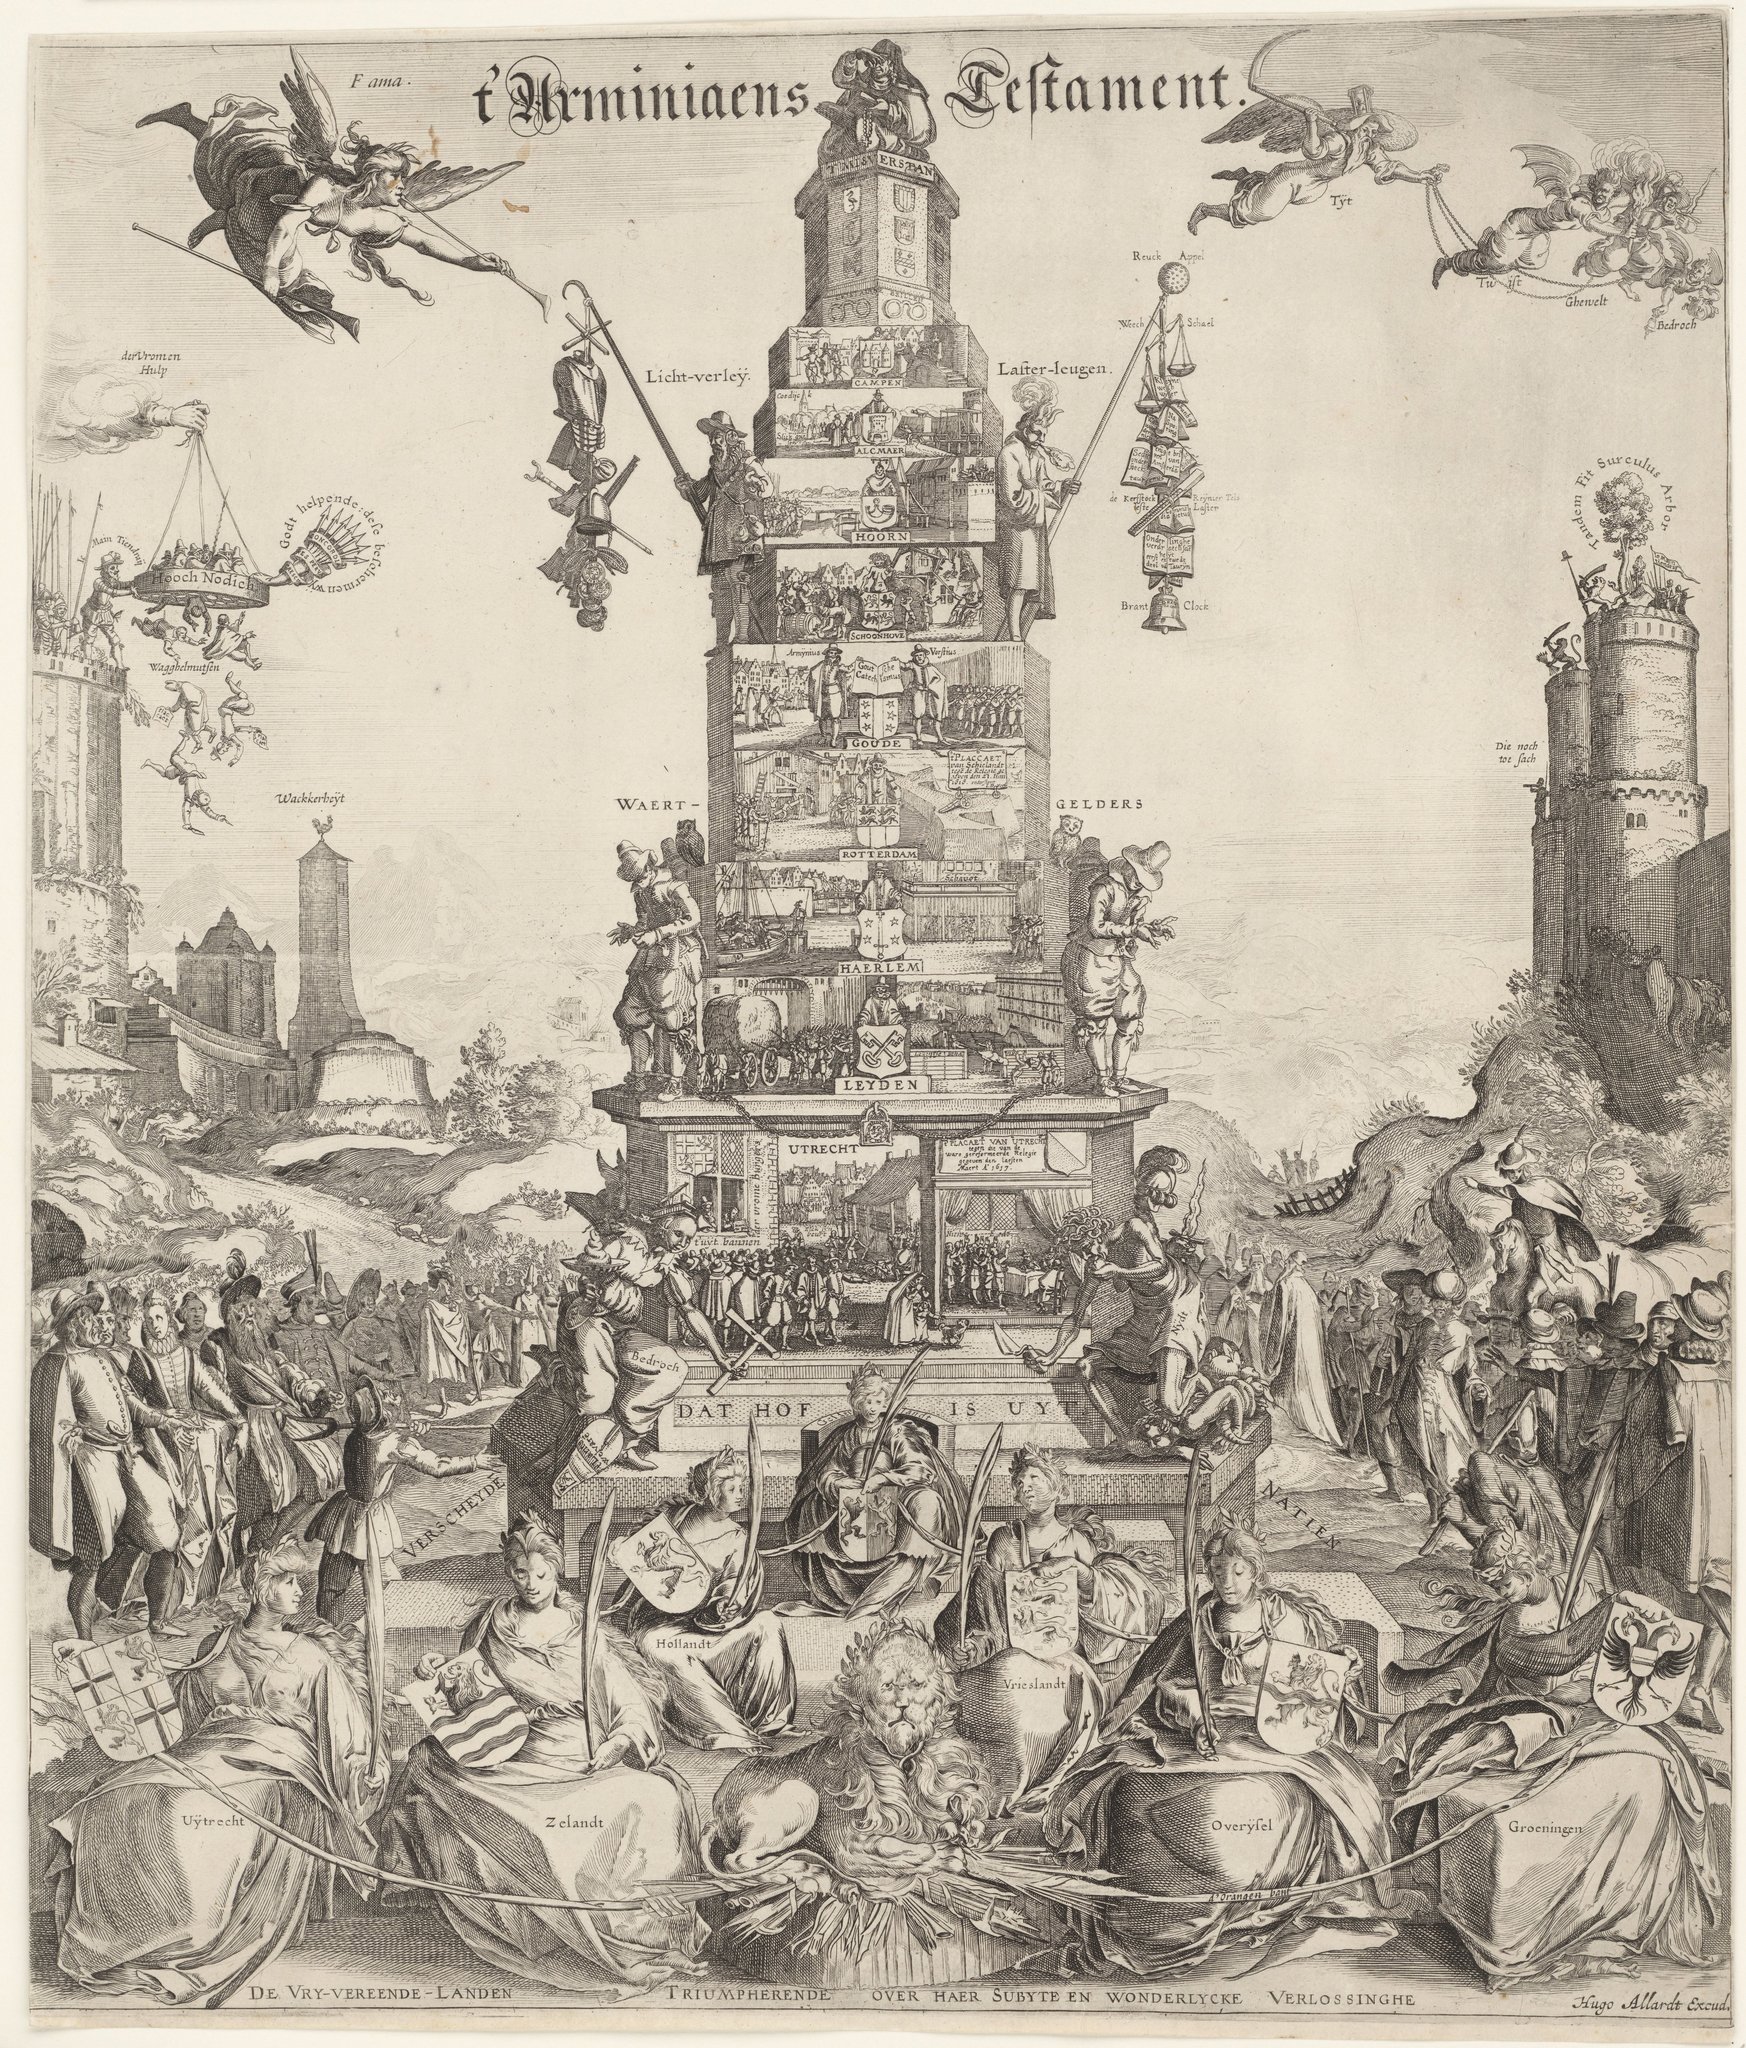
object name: print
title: t' Arminiaens Testament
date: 1609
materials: paper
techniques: engraving, etching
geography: amsterdam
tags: maurice (prince of orange), leiden, cologne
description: Gedetailleerde allegorische voorstelling waarin de arminianen bespot worden. De prent is een bewerking van een oude plaat van Simon Frisius vervaardigd in 1609 ter gelegenheid van het Bestand. Centraal in de voorstelling staat een toren met kleine scènes van de verrichtingen van de arminianen in de steden van Utrecht, Leiden, Haarlem, Rotterdam, Gouda, Schoonhoven, Hoorn, Alkmaar en Kampen. Op de toren staan de waardgelders en personificaties van Afgunst, Bedrog, Laster, Verleiding en Dwaling. Op de voorgrond, aan de voet van de toren, zitten de zeven provinciemaagden. Links en rechts torens van de prins van Oranje en de Nederlandse Leeuw. In de lucht vliegen Faam en Tijd.